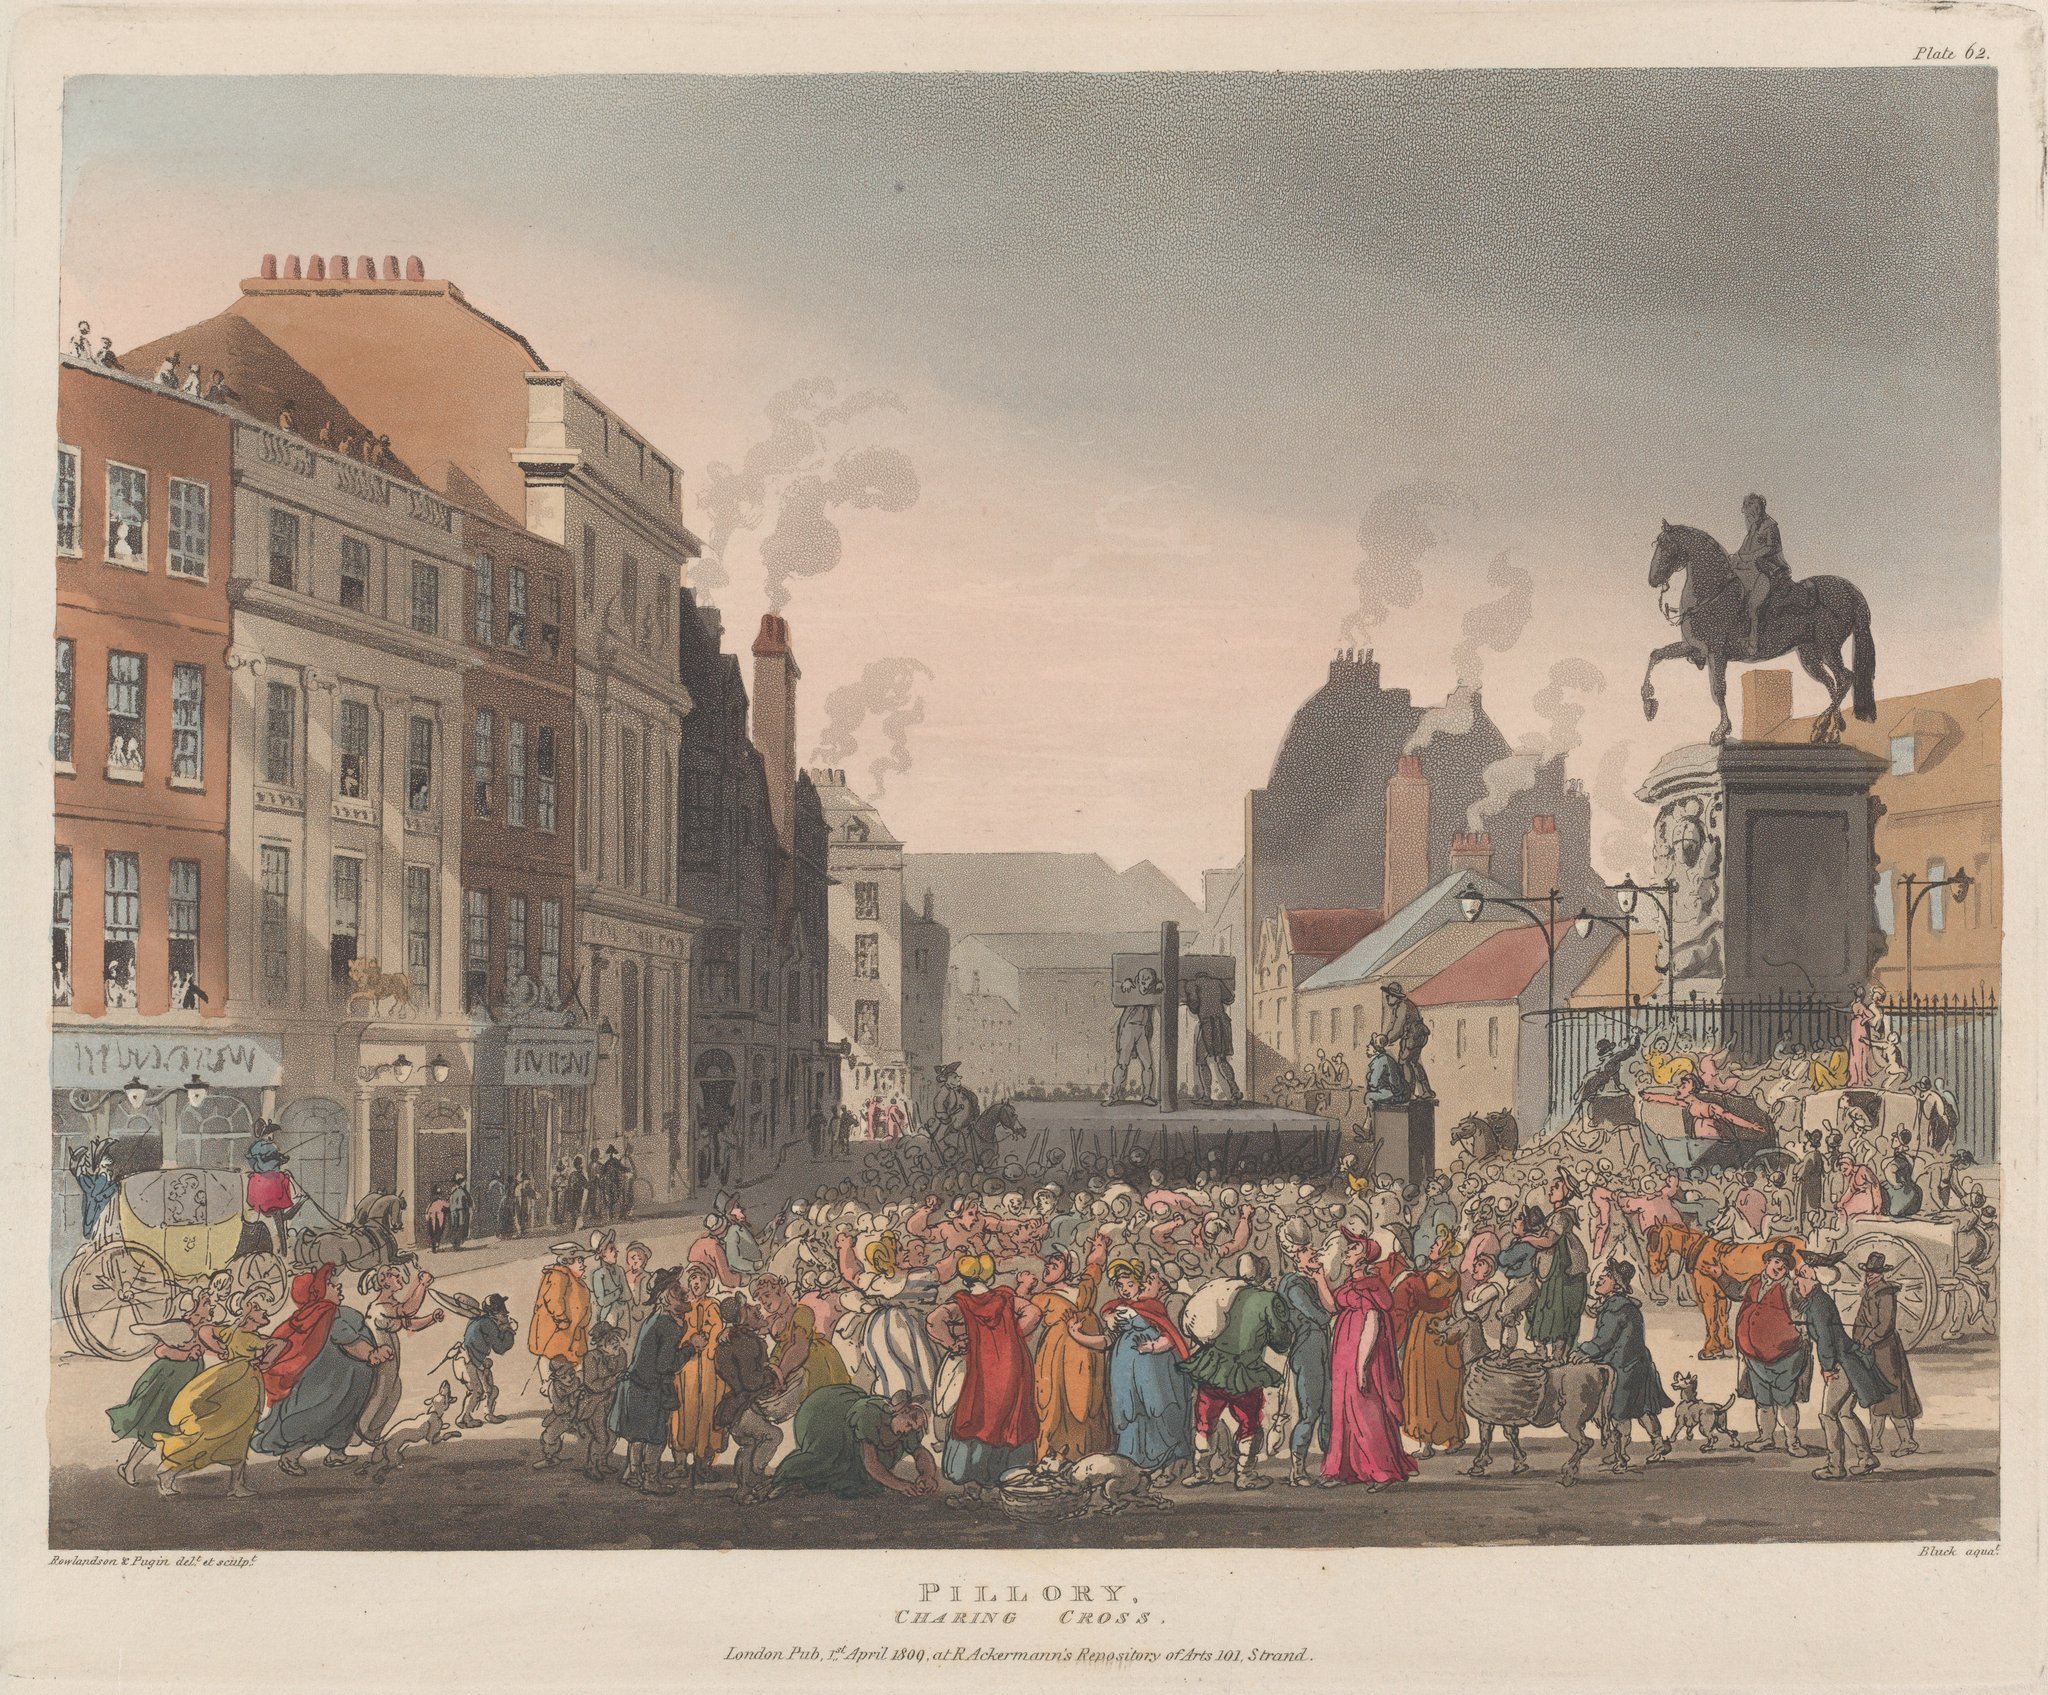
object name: print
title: Pillory, Charing Cross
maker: thomas rowlandson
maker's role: artist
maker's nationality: british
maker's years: 1757-1827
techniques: aquatint, etching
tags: cities,crowd,punishment,london